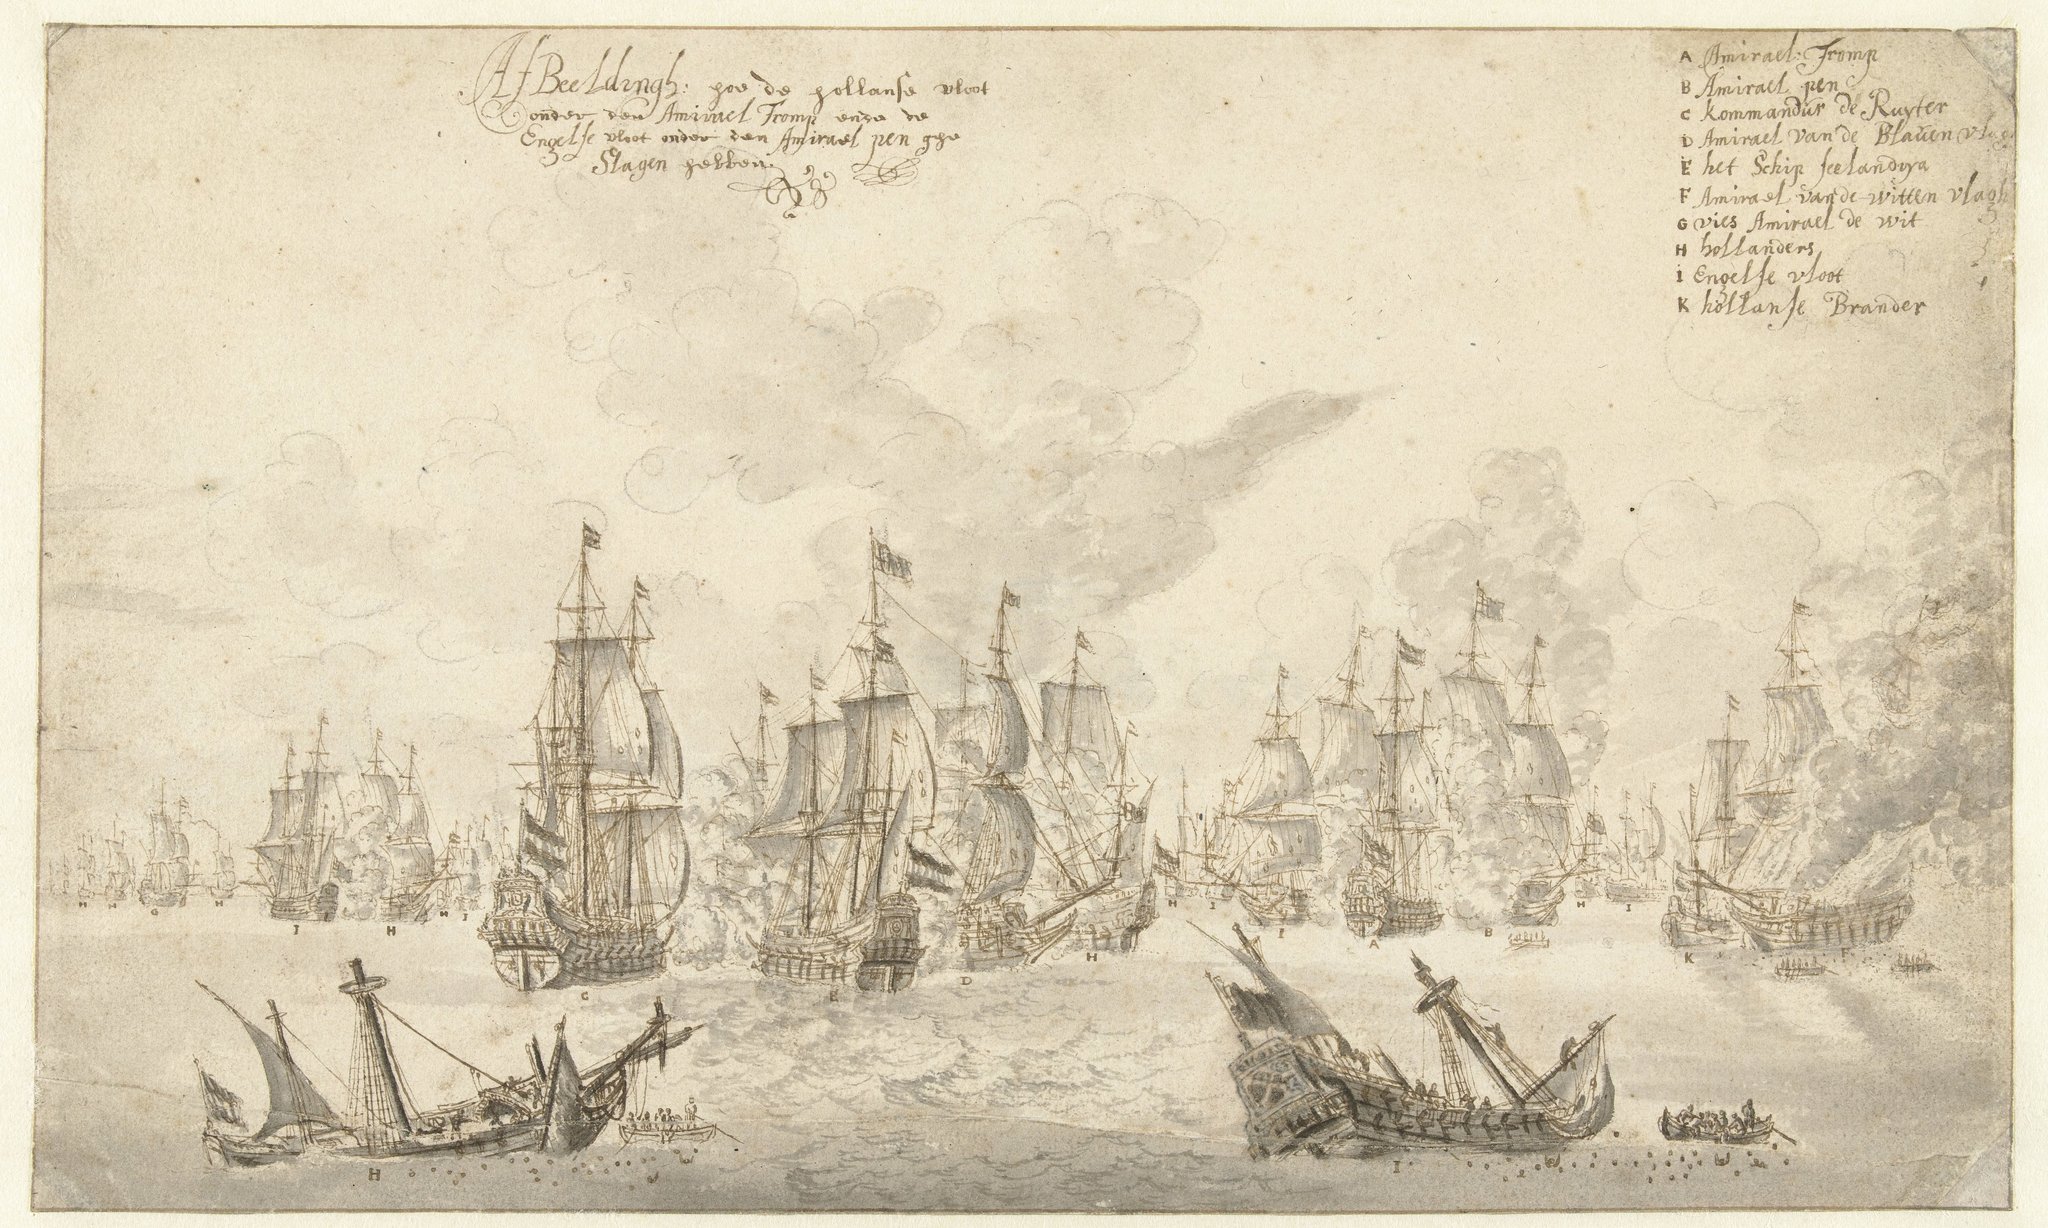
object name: historieplaat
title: Afbeeldingh: hoe de hollanse vloot onder den Amirael Tromp ende de Engelse vloot onder den Amirael pen gheslagen hebben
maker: jan abrahamsz. beerstraten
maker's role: draughtsman, painter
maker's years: 1622-1666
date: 1653-1666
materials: ink, paper, pencil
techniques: brush, pen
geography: northern netherlands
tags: brielle, maarten harpertszoon tromp, battle (+ naval force), battle of scheveningen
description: Zeeslag bij Terheide in de Eerste Engelse Oorlog tussen de Staatse vloot onder Maarten Tromp en de Engelse vloot onder George Monck, 10 augustus 1653. Rechtsboven de legenda A-K.